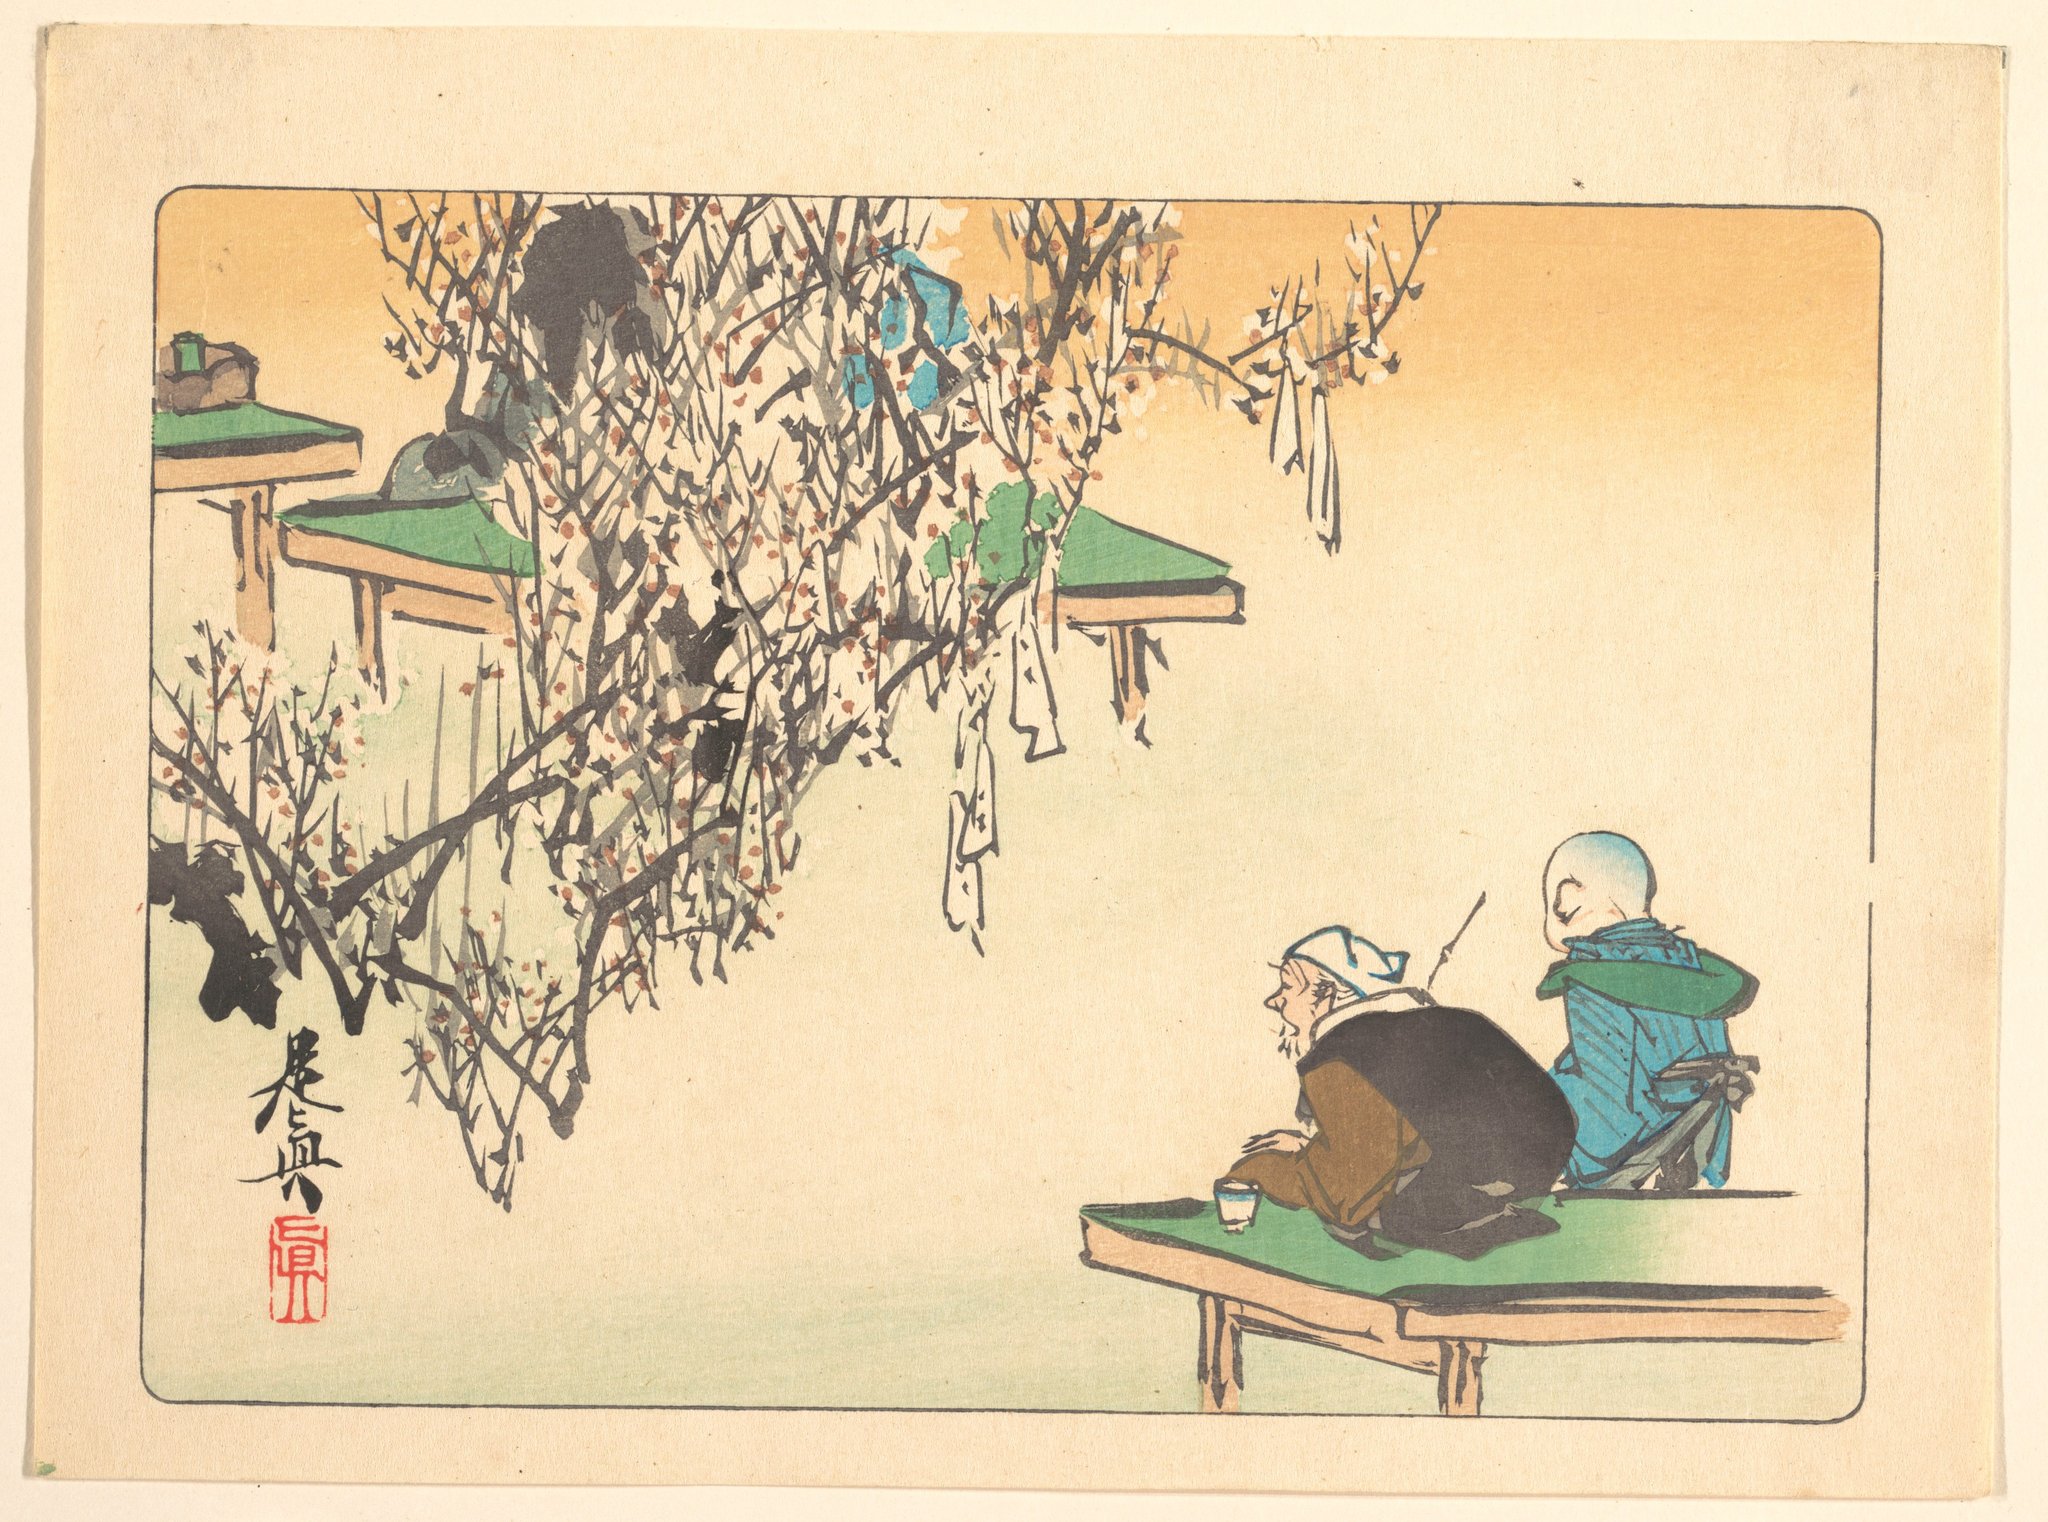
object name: print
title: Two Pilgrims Gazing at a Tree Festooned with Prayers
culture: japanese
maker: shibata zeshin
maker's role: artist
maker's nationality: japanese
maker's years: 1807-1891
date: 1807-1891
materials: ink, paper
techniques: woodblock print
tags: men,trees